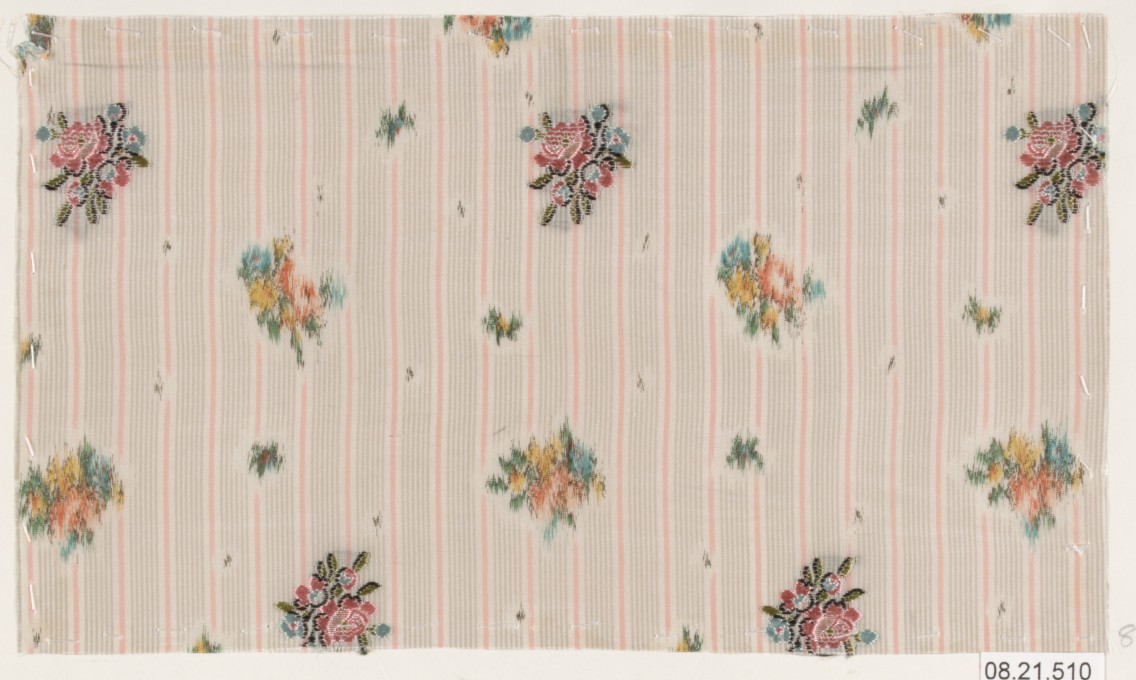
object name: textile sample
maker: Anonymous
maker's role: designer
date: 1900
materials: silk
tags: flowers